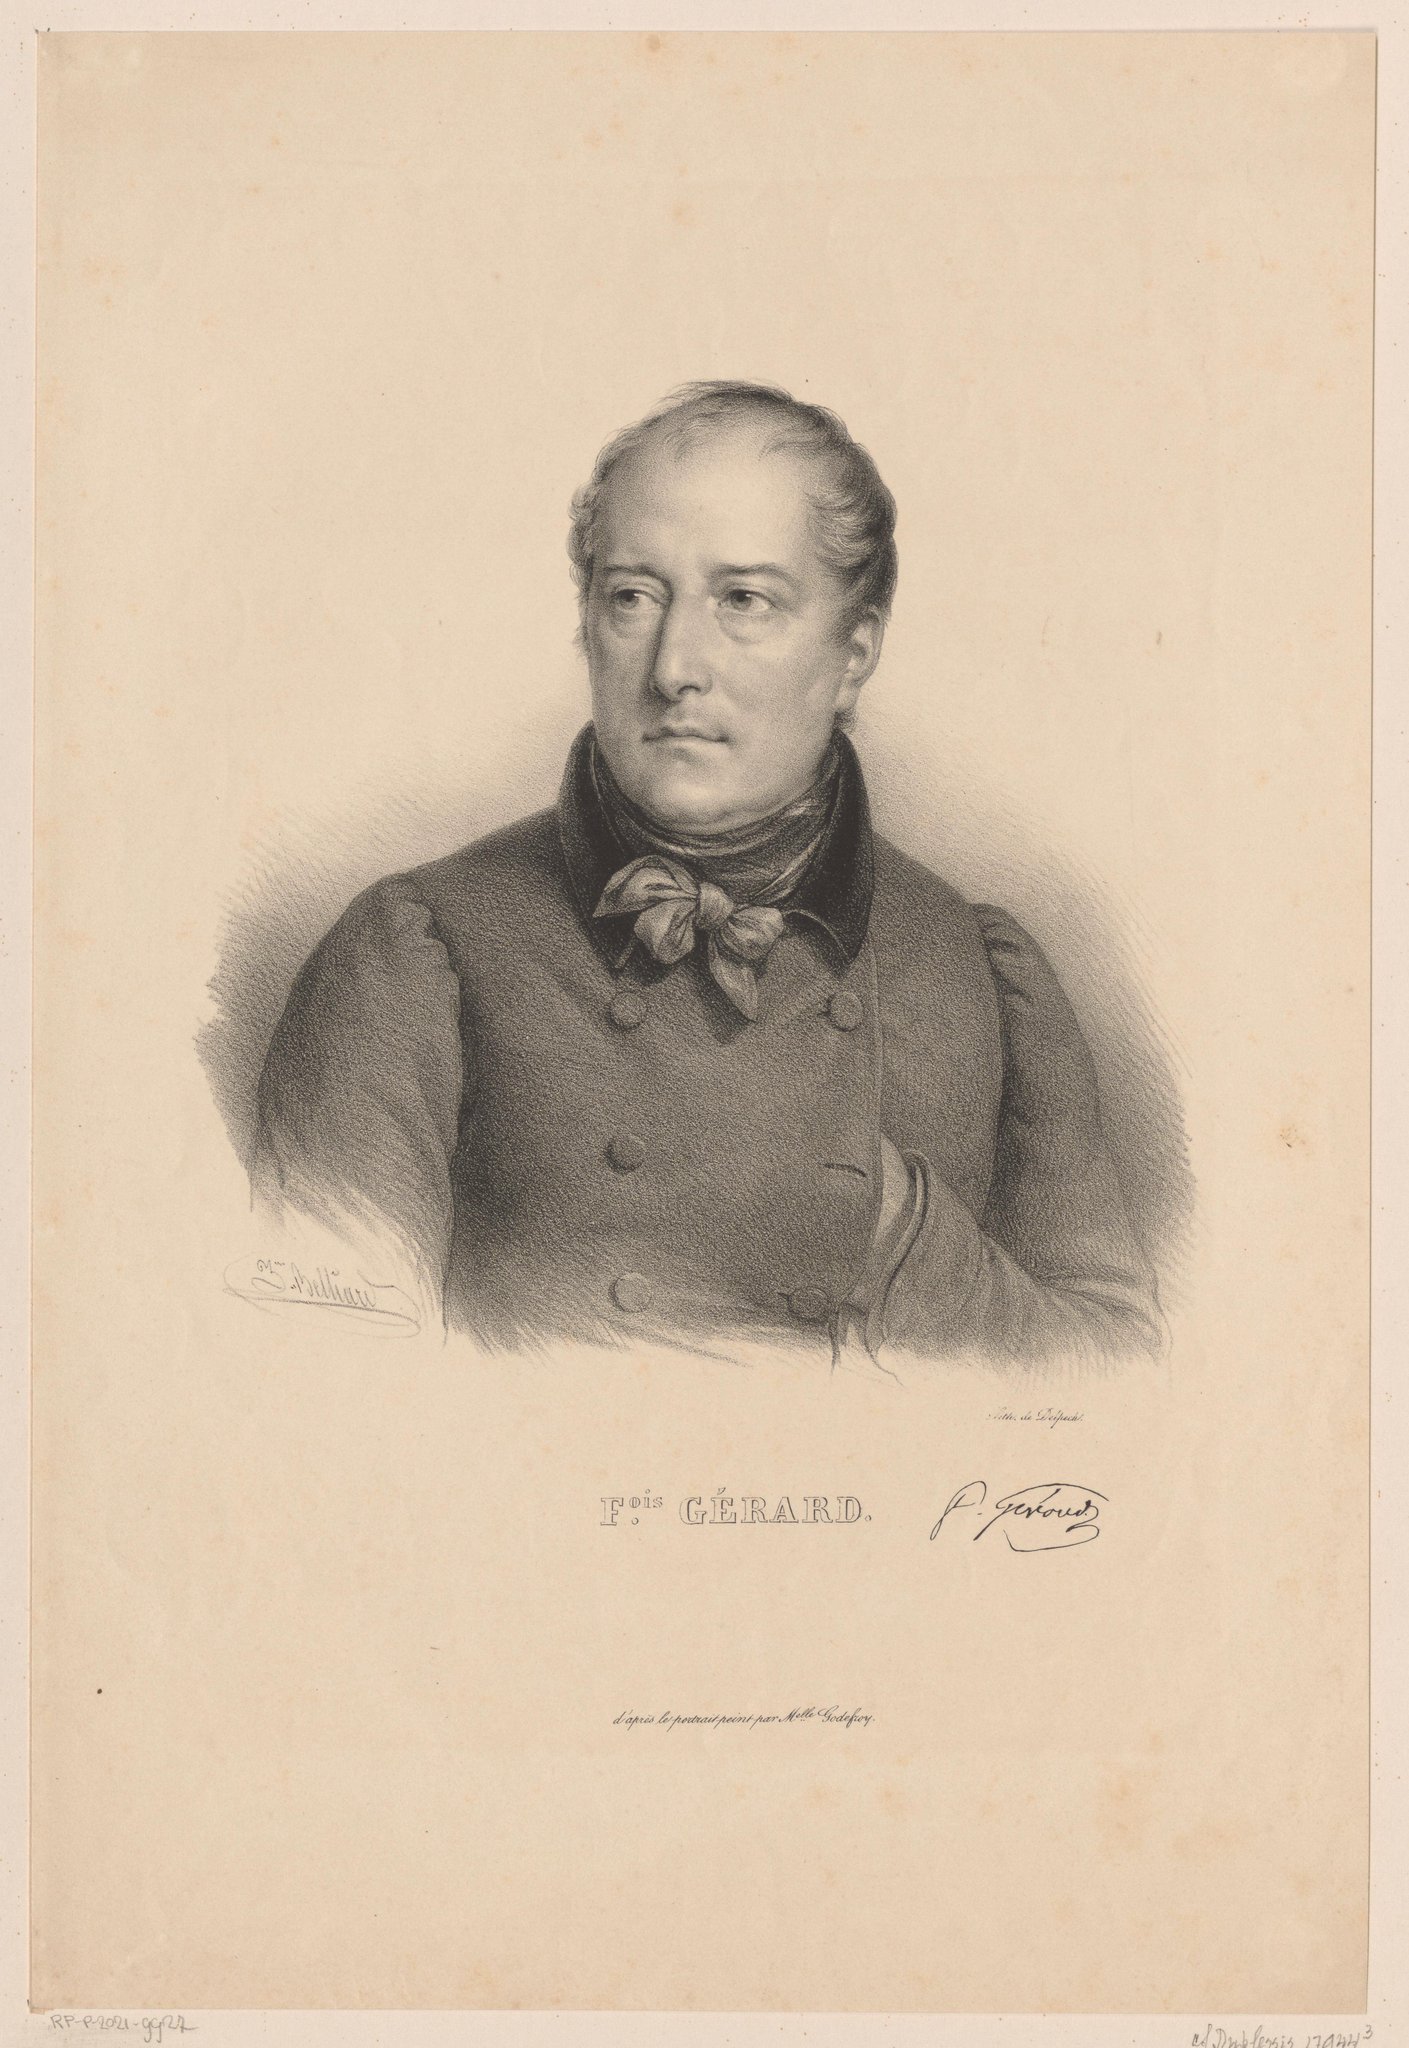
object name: print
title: Portret van François Gérard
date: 1818-1842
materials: paper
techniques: lithograph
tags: rome, paris, painter, françois gérard, historical persons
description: Onder het portret een facsimile van de handtekening van de geportretteerde.